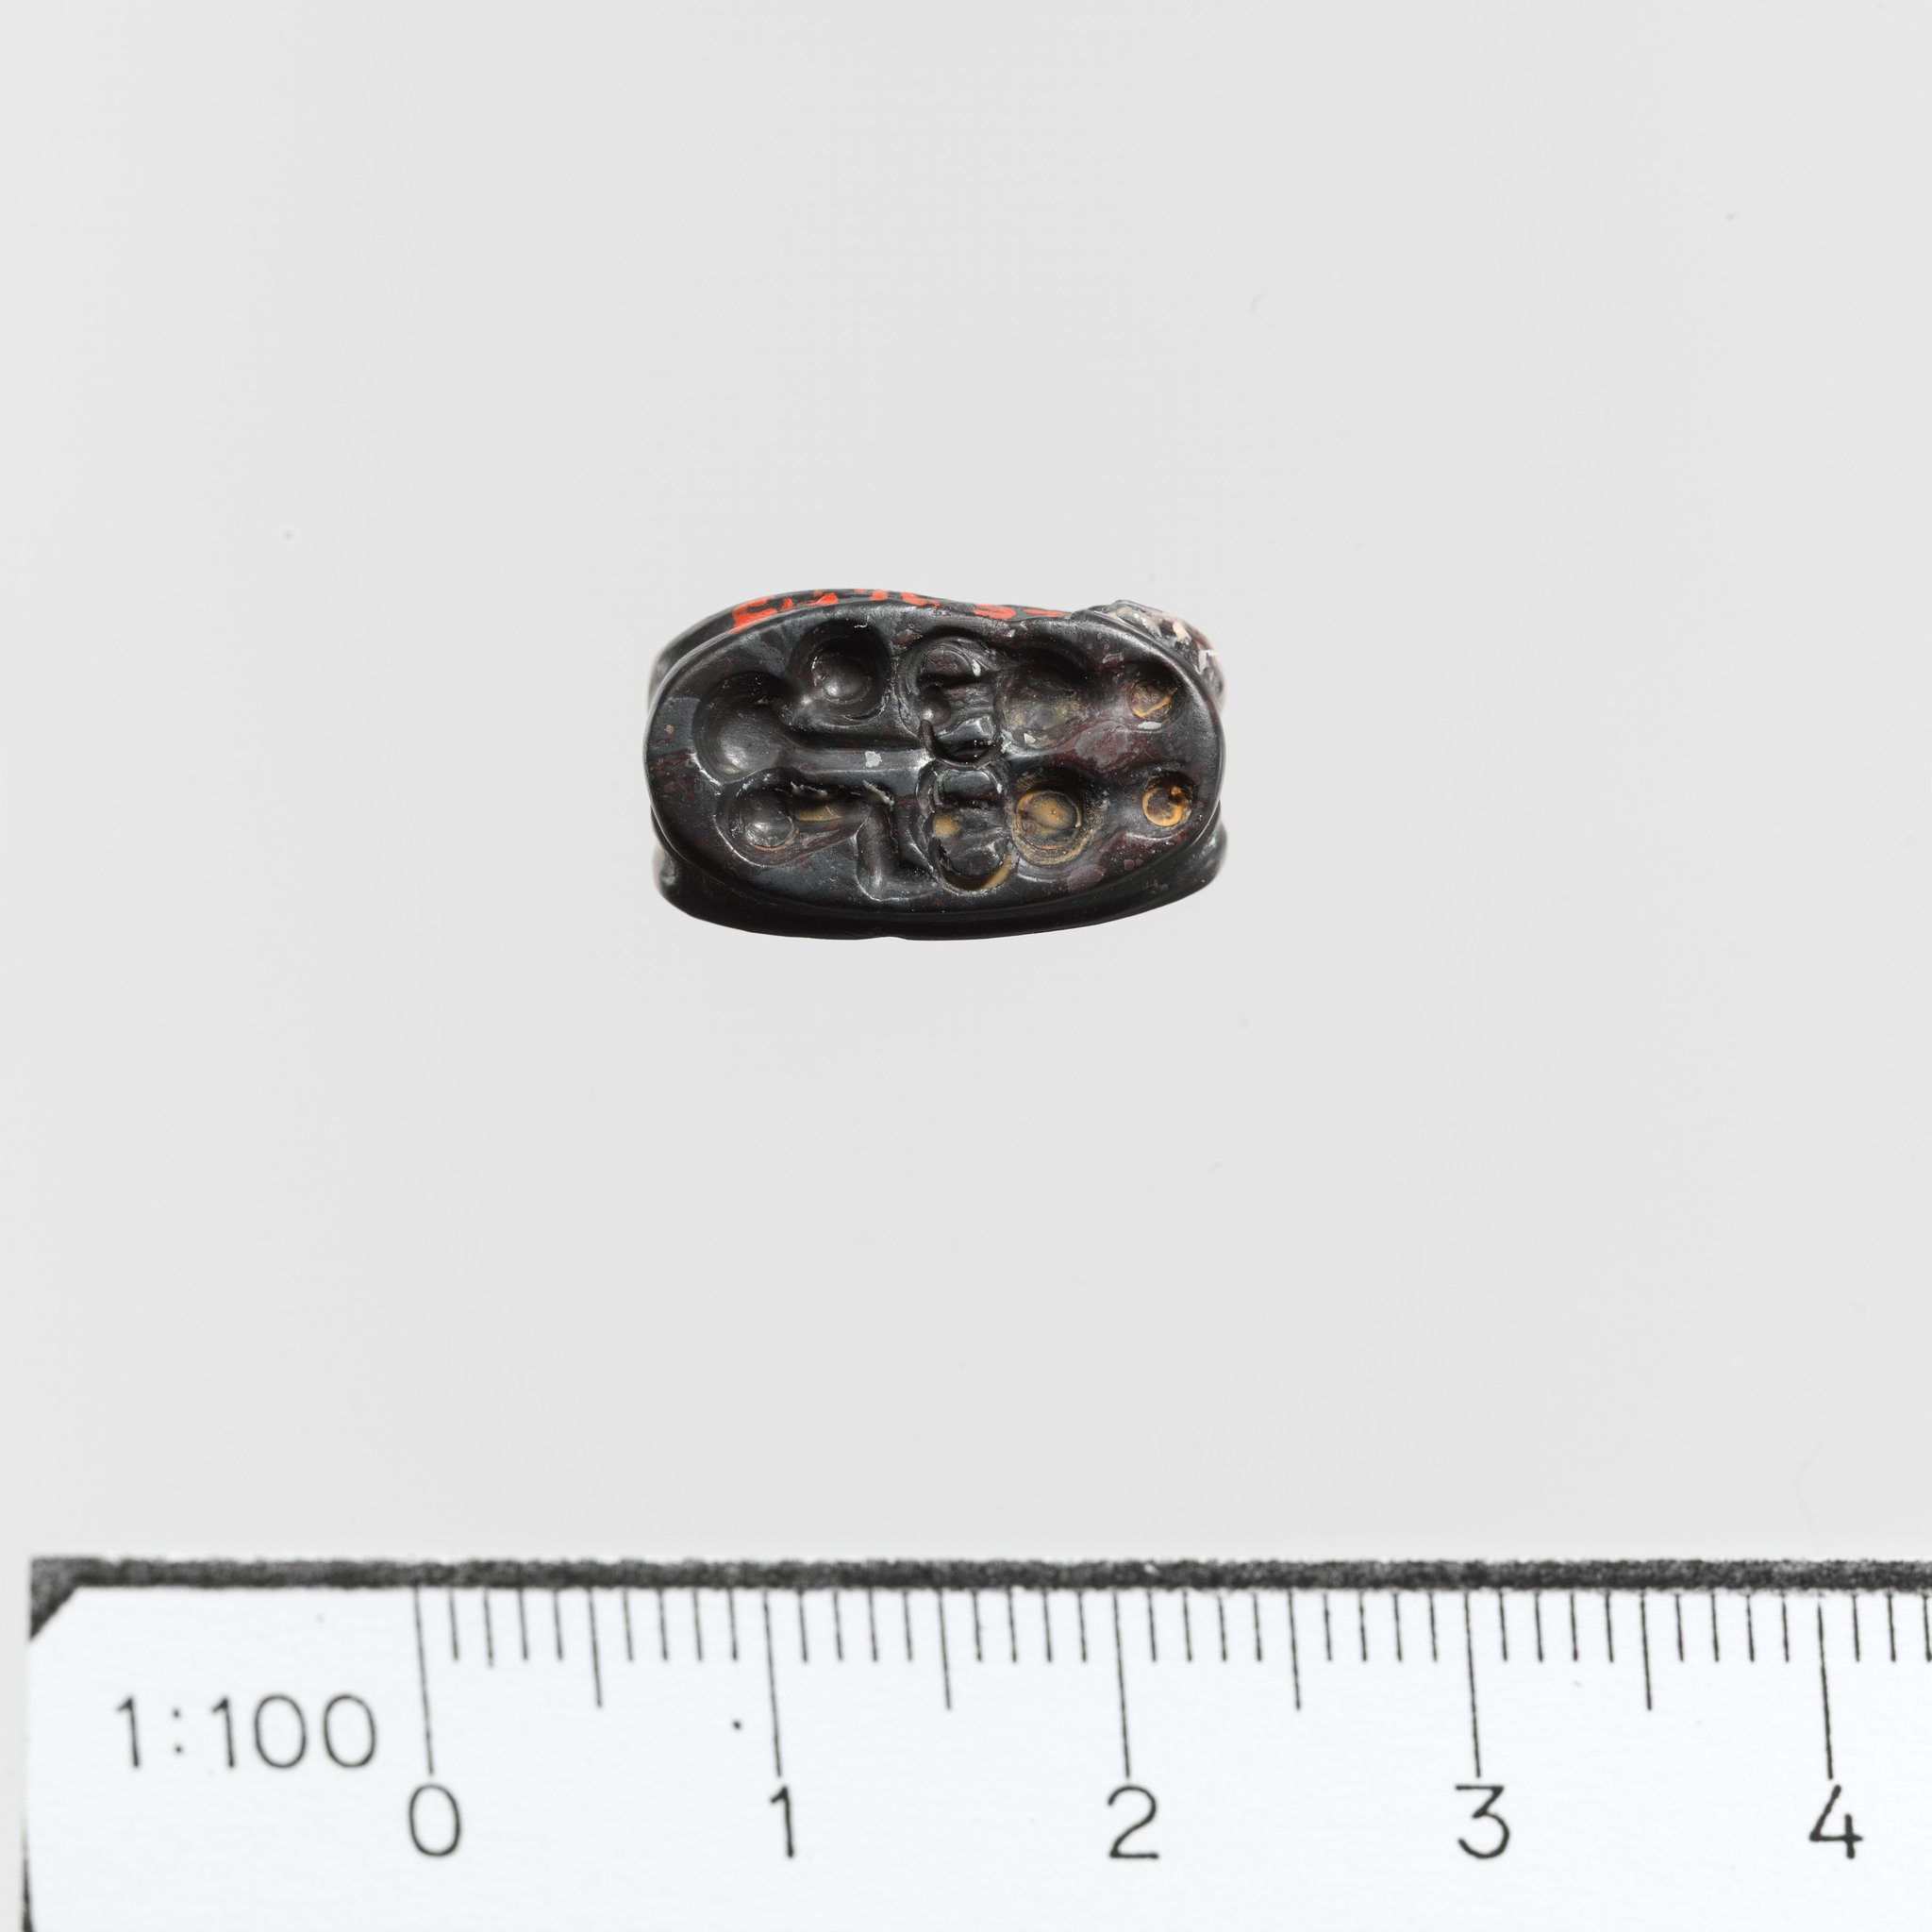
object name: seal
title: Jasper triangular prism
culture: minoan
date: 1750-1600 BCE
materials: jasper